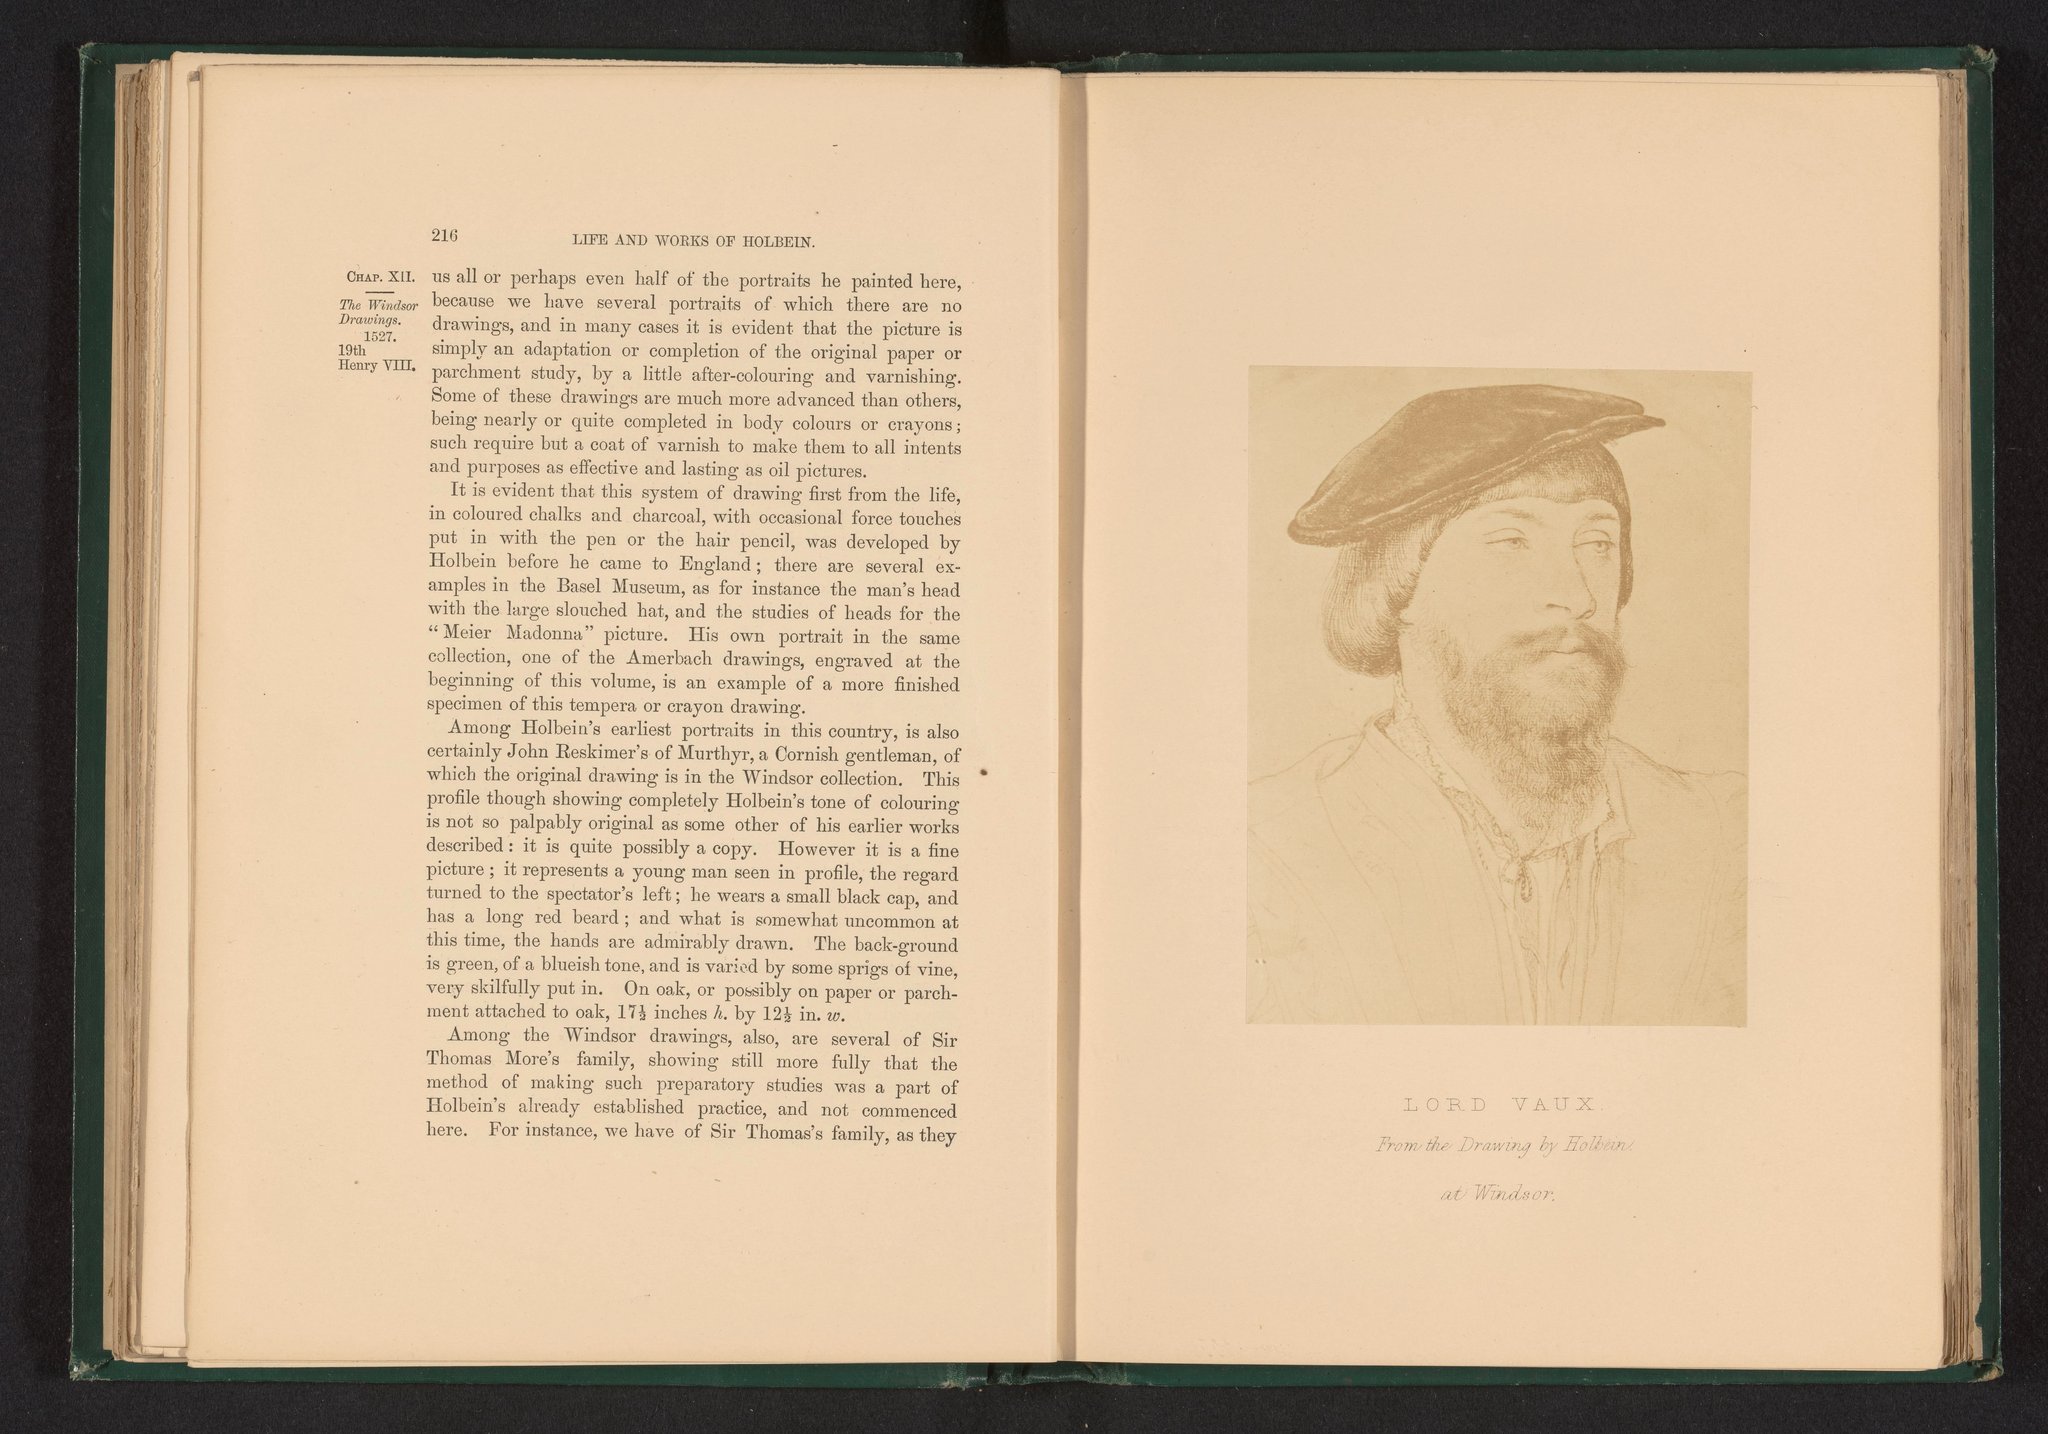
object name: page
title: Lord Vaux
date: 1857-1867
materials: photographic support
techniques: albumen print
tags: writer, poet, author